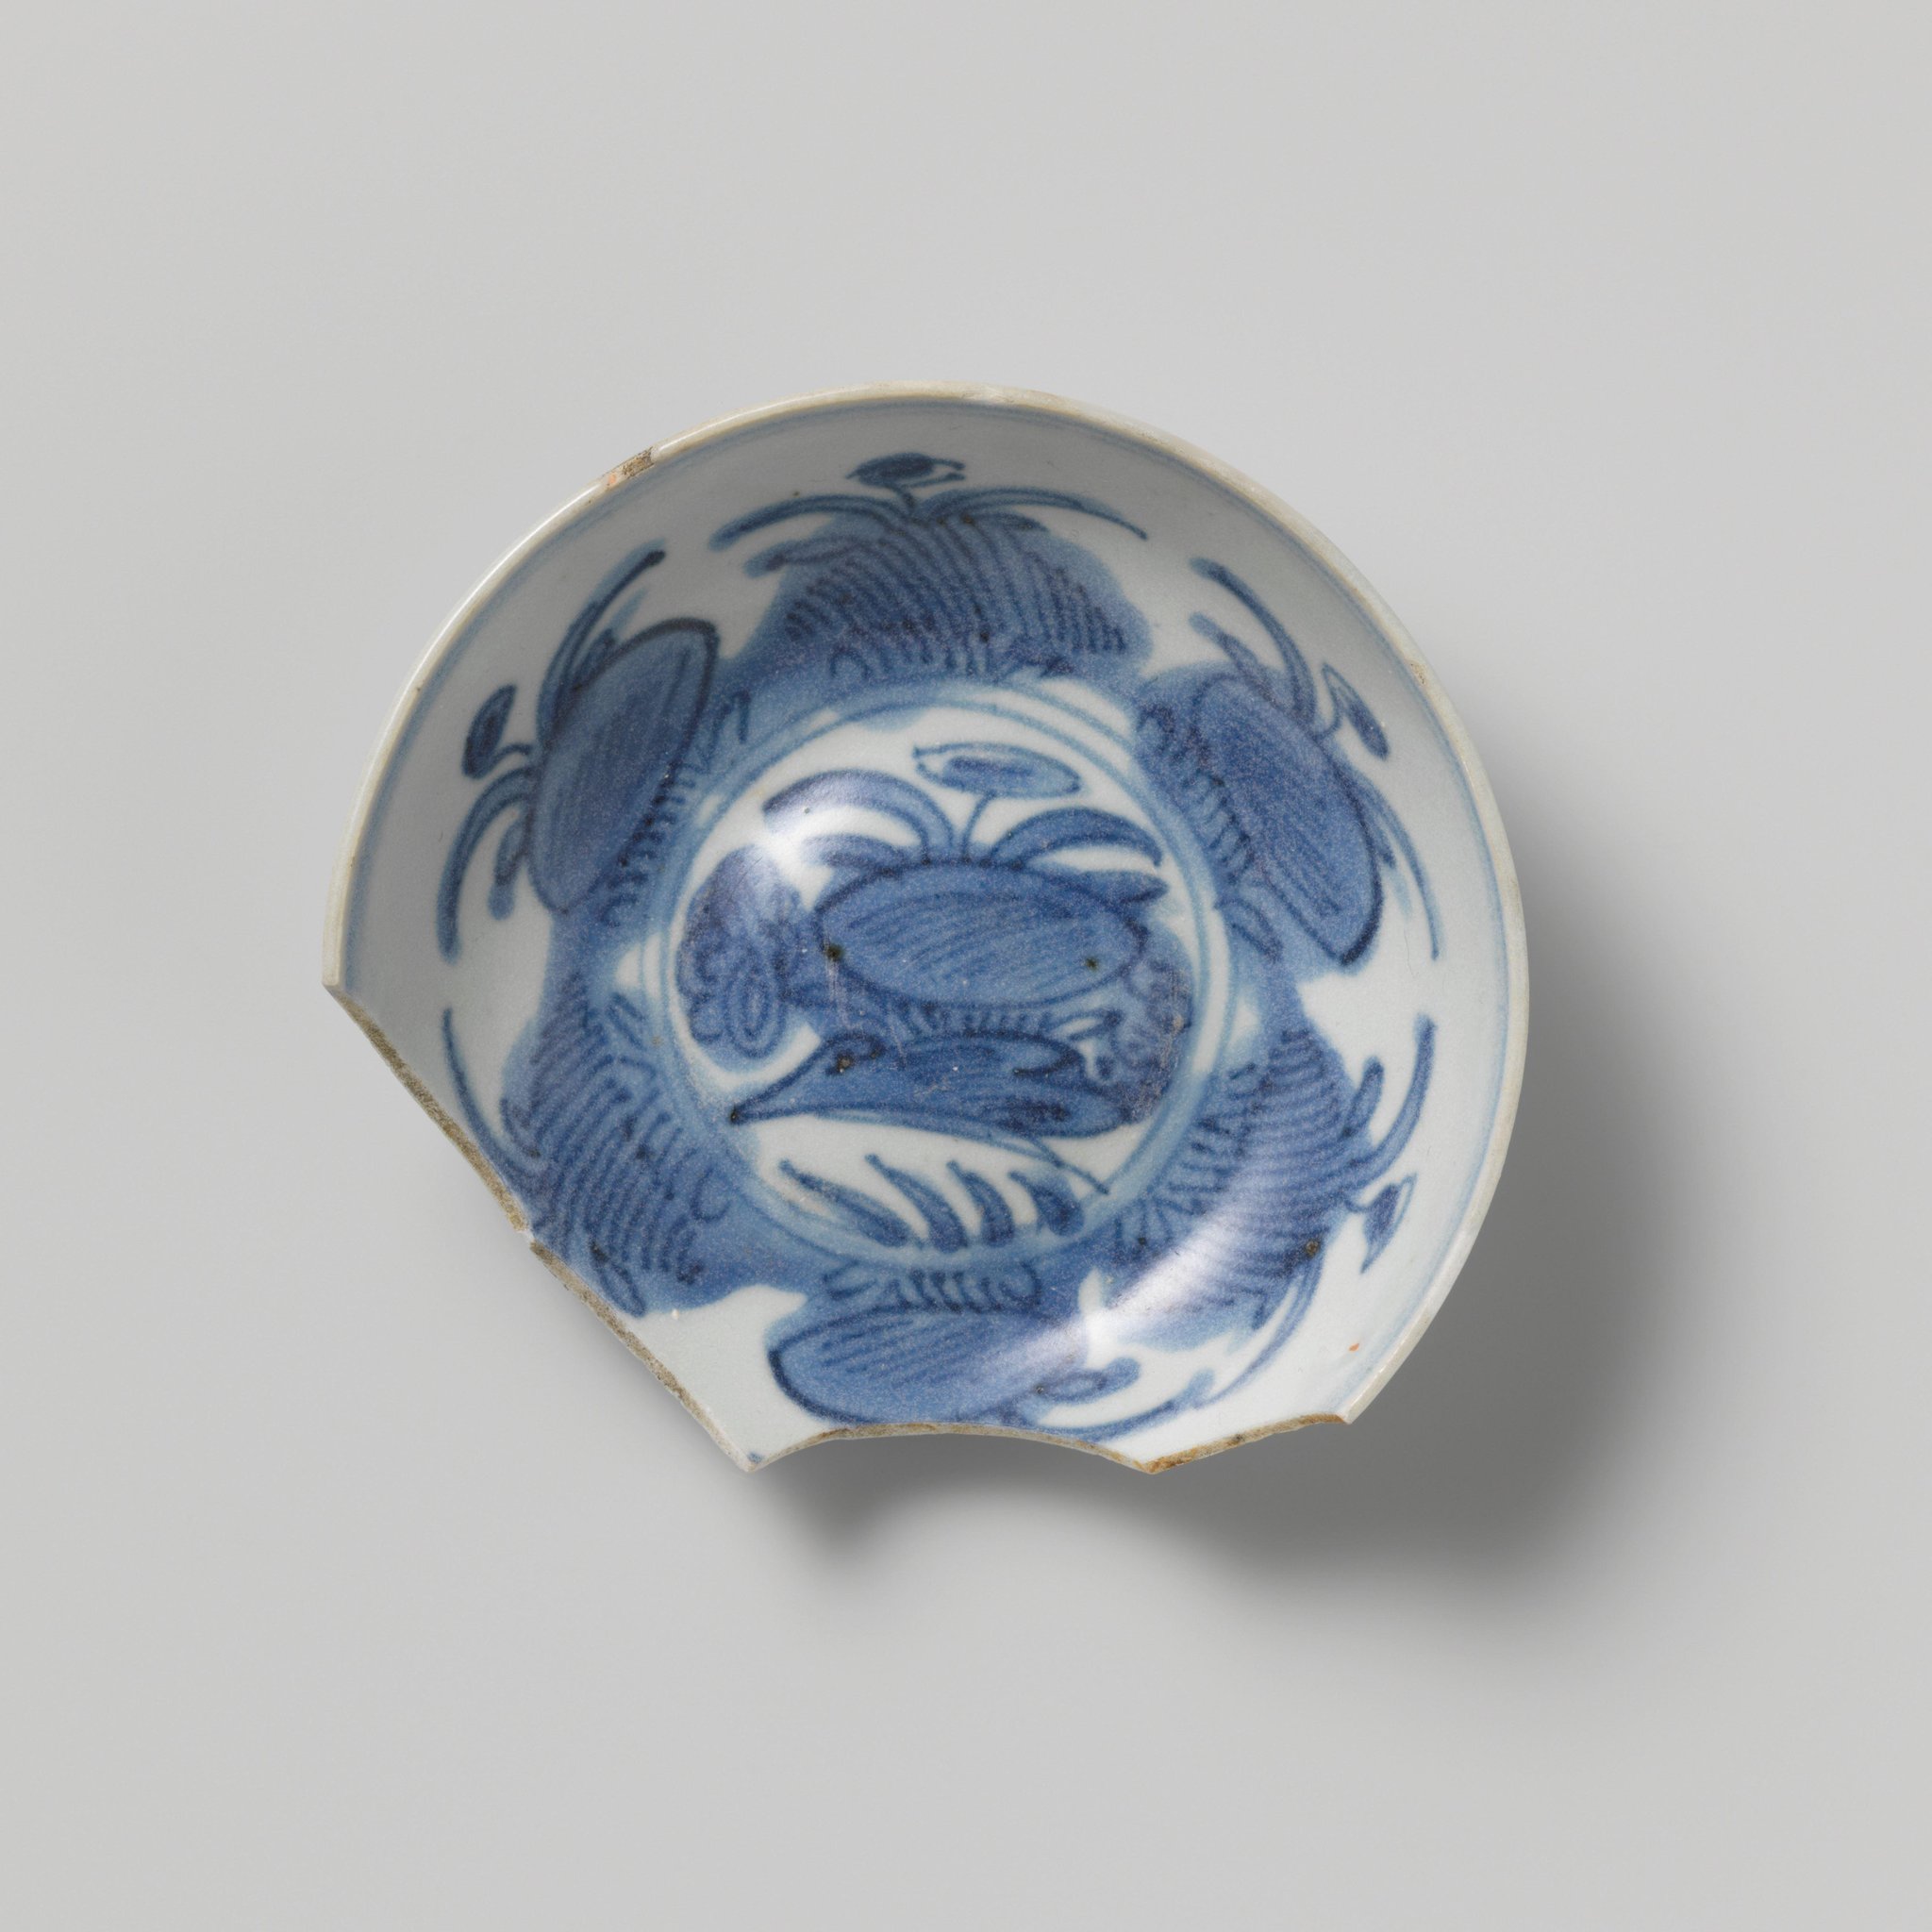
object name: platter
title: Fragment bord of schotel van porselein uit V.O.C.-schip de 'Witte Leeuw'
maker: Anonymous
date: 1613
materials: porcelain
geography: jingdezhen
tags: verenigde oostindische compagnie, sint-helena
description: Fragment bord of schotel van porselein uit V.O.C.-schip de 'Witte Leeuw', 75% aanwezig.